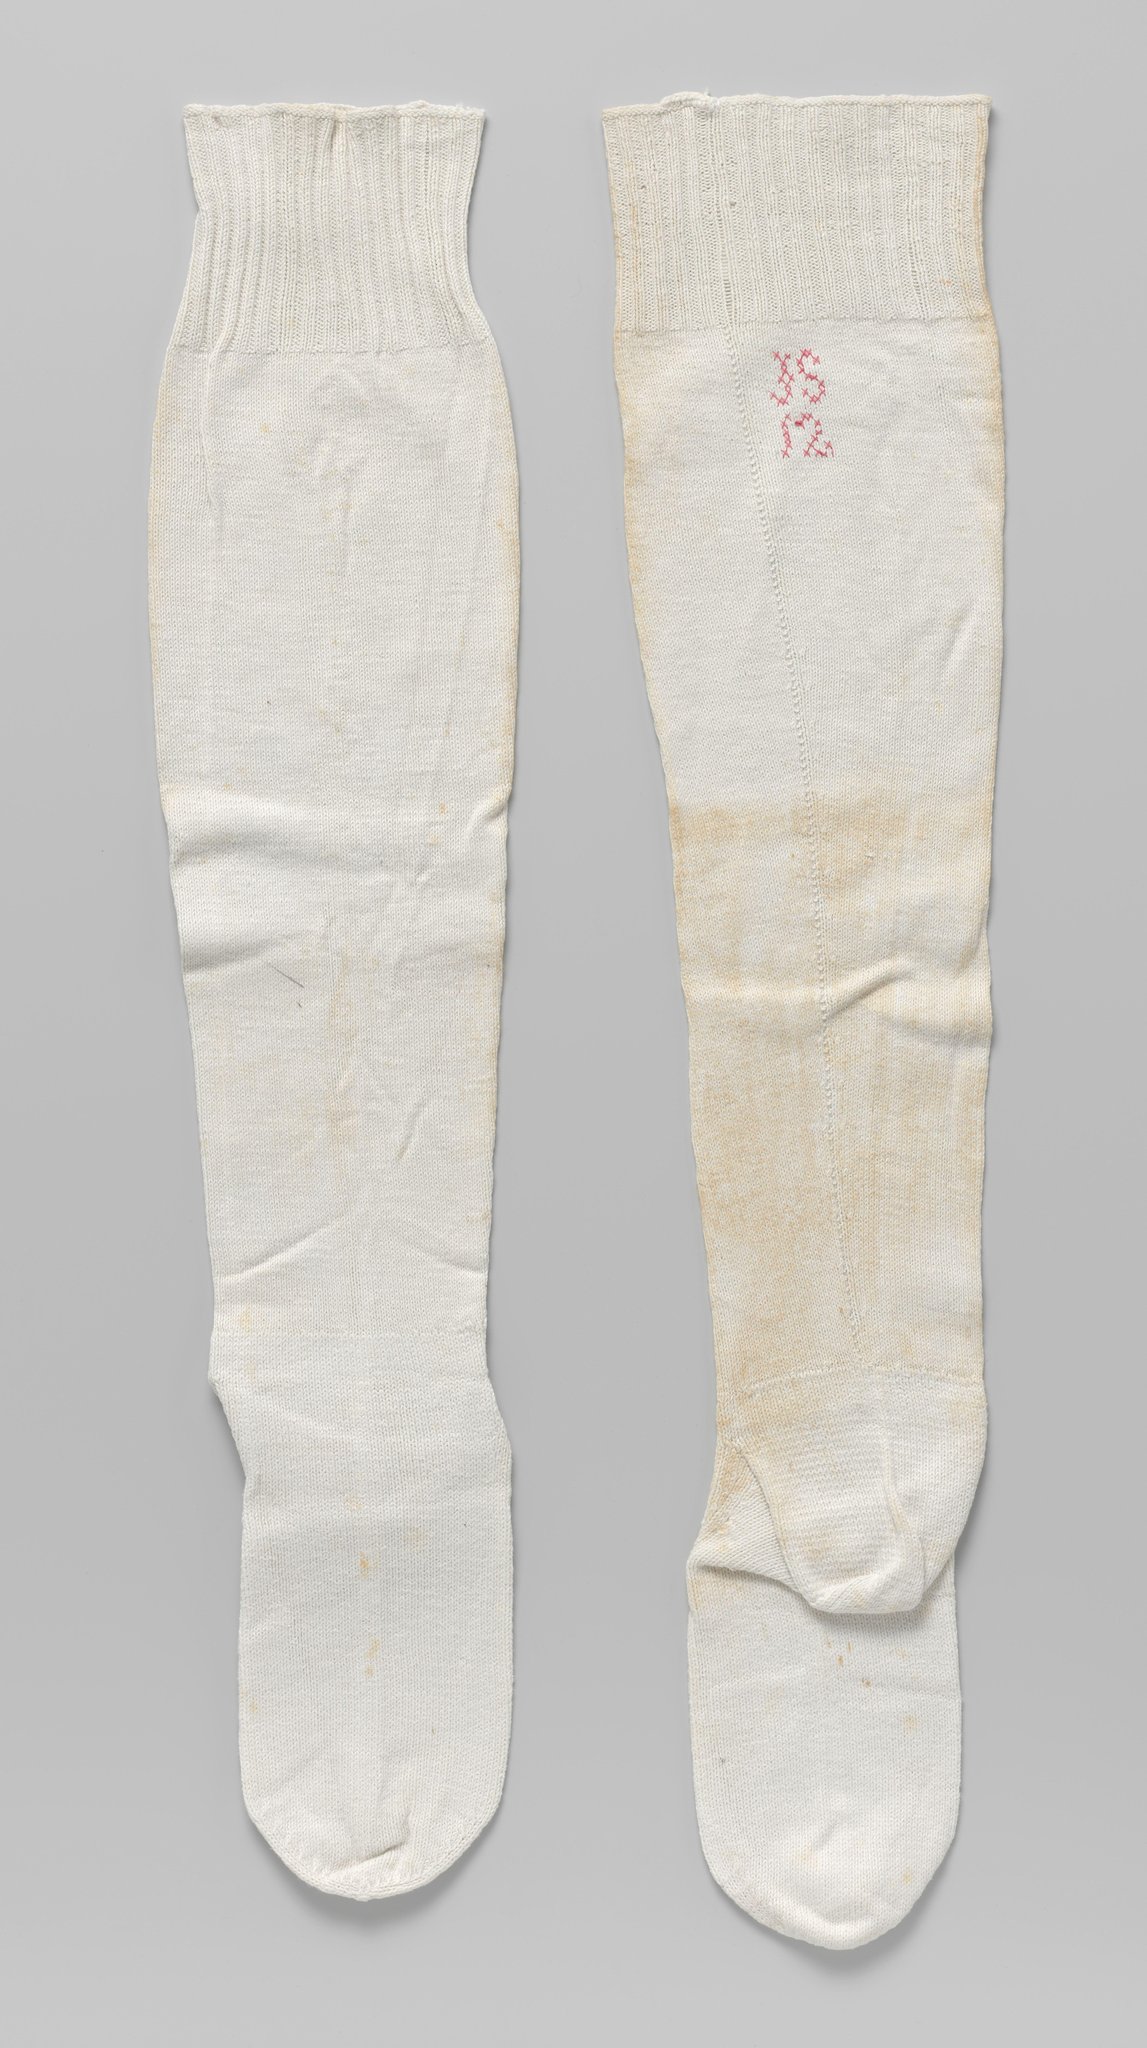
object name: menswear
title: Herenkous van wit katoenen breiwerk; in rode kruissteek gemerkt: J.S./12.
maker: Anonymous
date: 1875-1925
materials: cotton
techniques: cross stitching, knitting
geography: amsterdam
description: Herenkous van wit katoenen breiwerk; in rode kruissteek gemerkt: J.S./12.